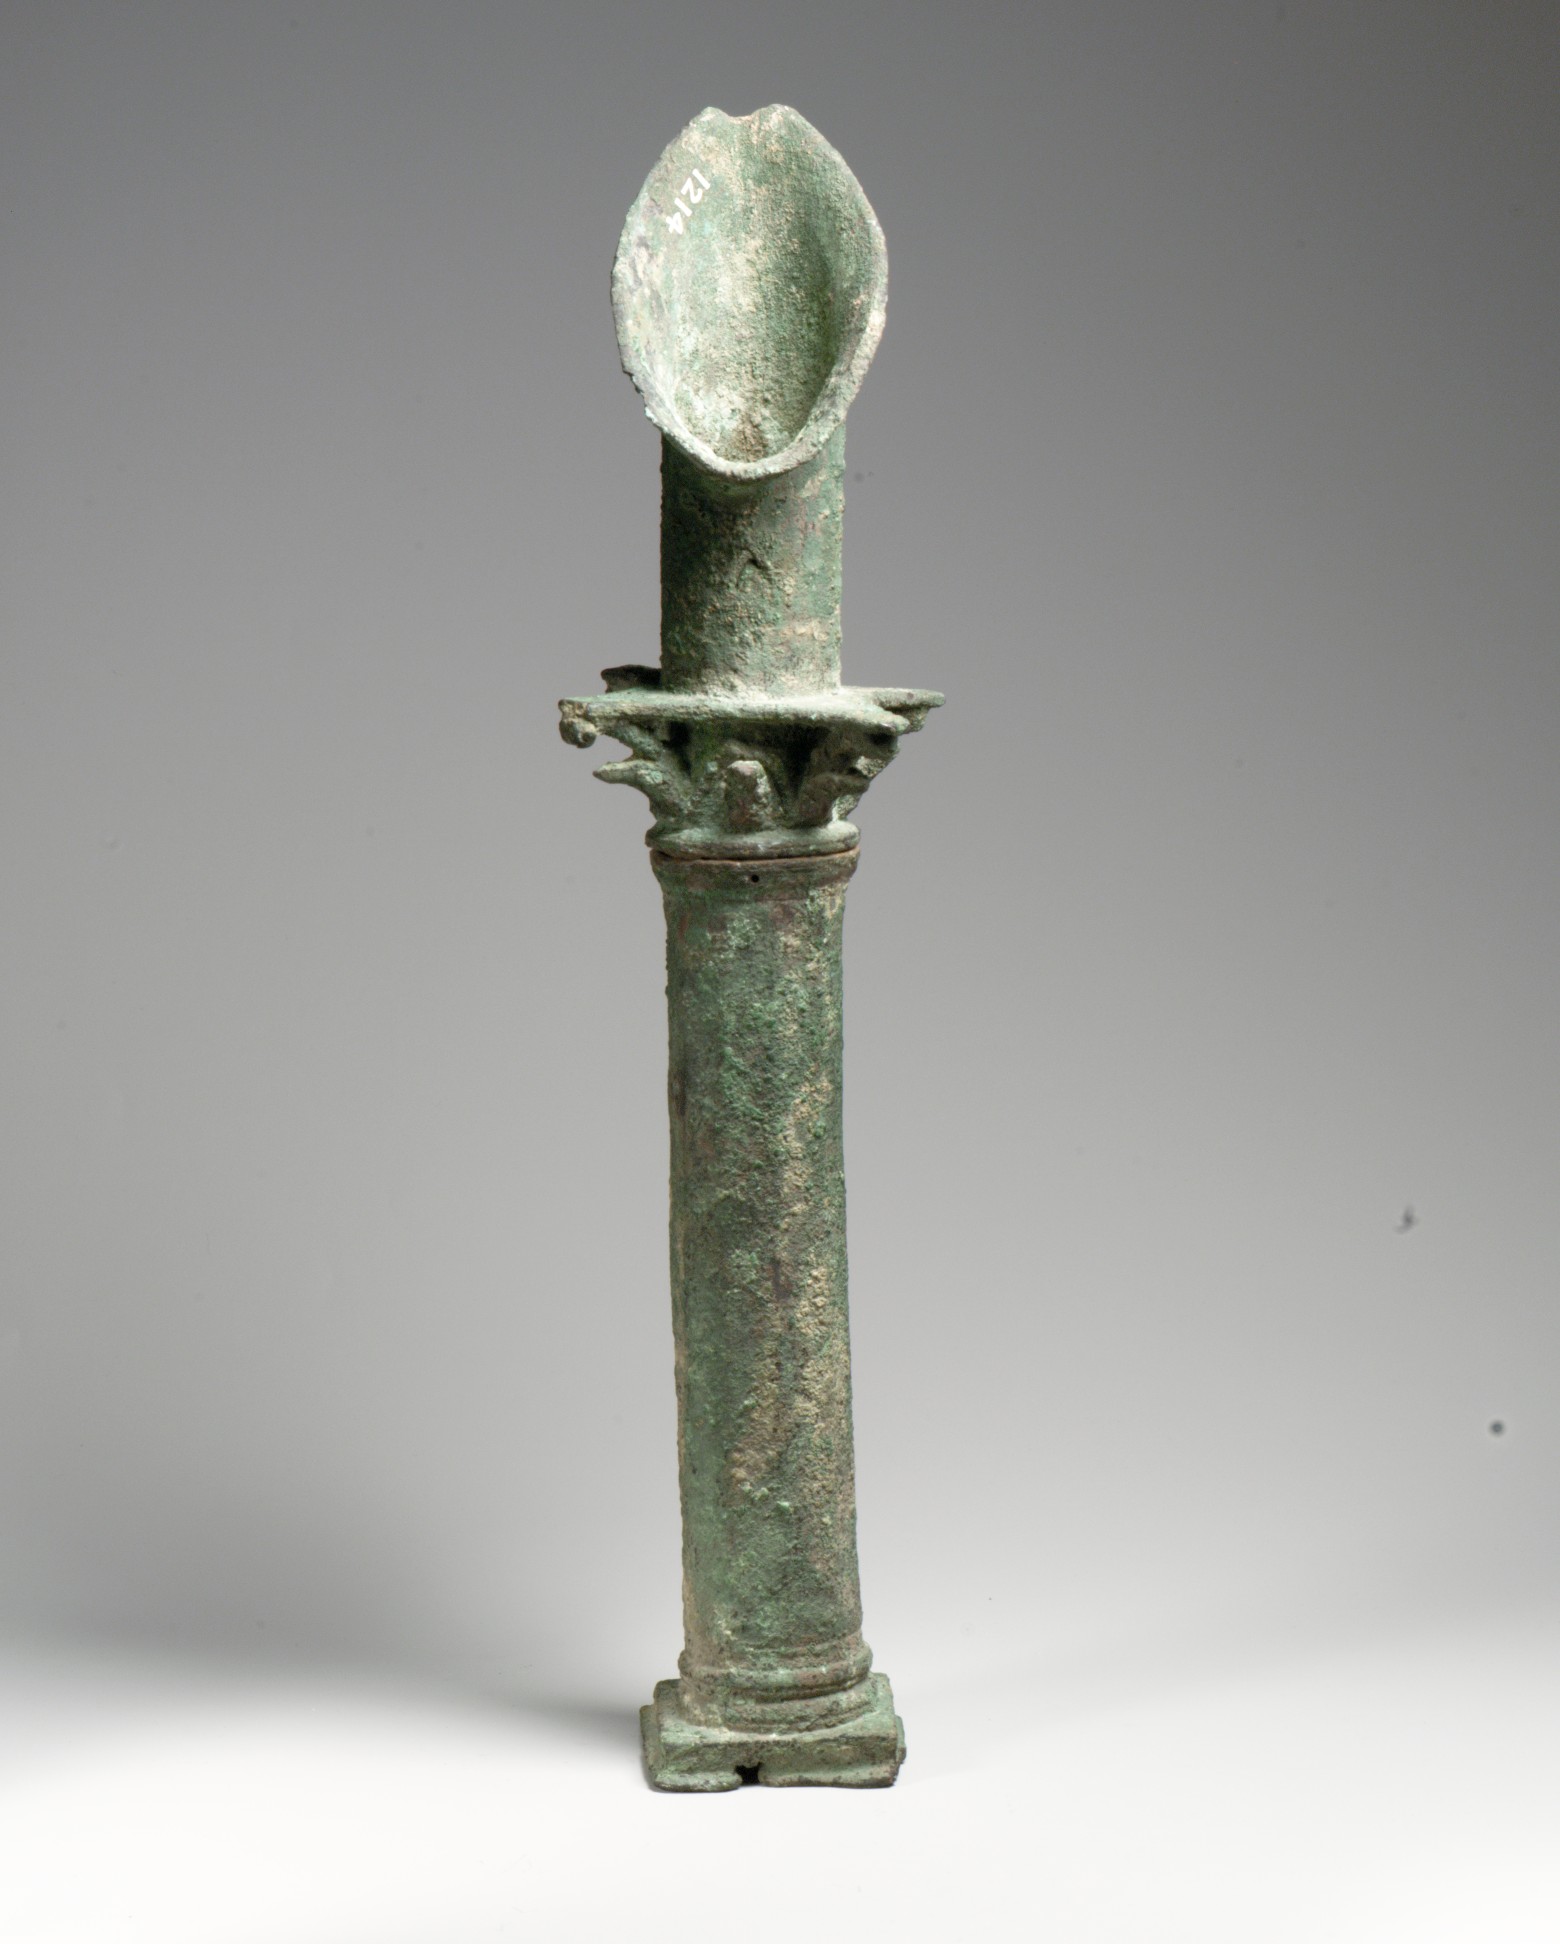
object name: spout in the form of a column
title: Bronze spout in the form of a Corinthian column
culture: roman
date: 1-200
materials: bronze